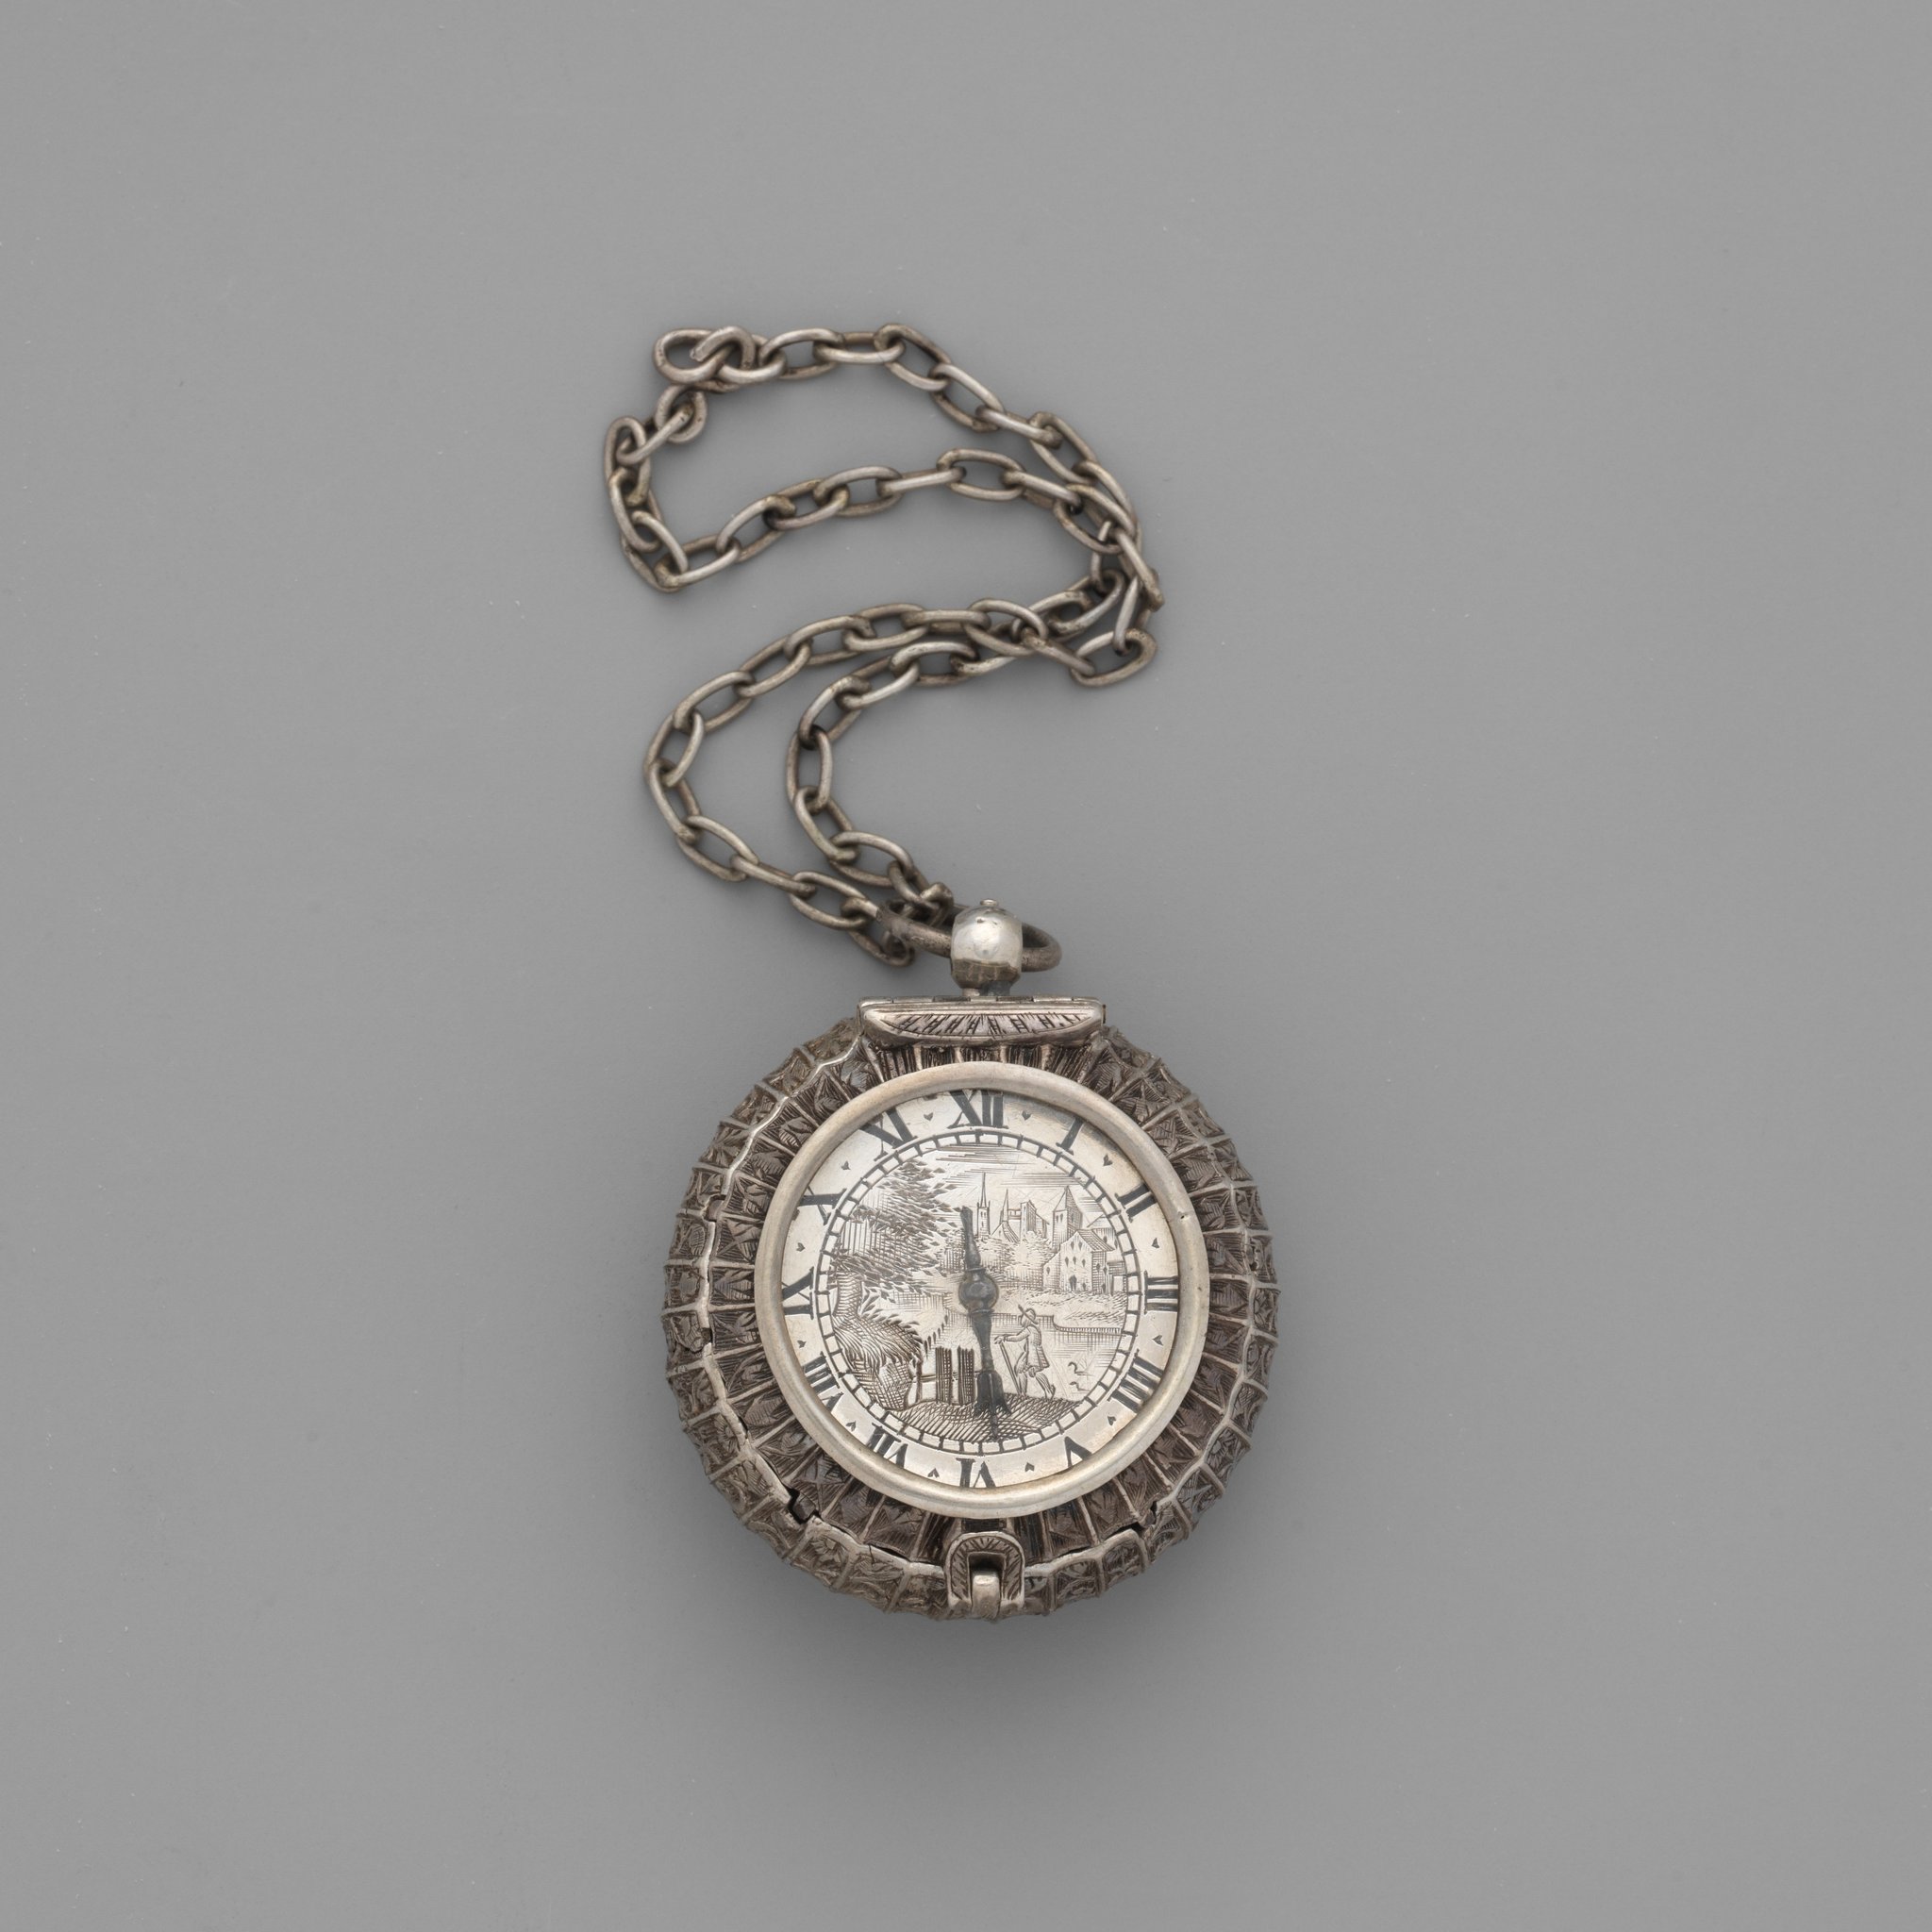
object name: watch with key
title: Watch and key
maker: edward east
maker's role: maker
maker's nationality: british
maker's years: 1602-1697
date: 1640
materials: gilt brass, silver, steel